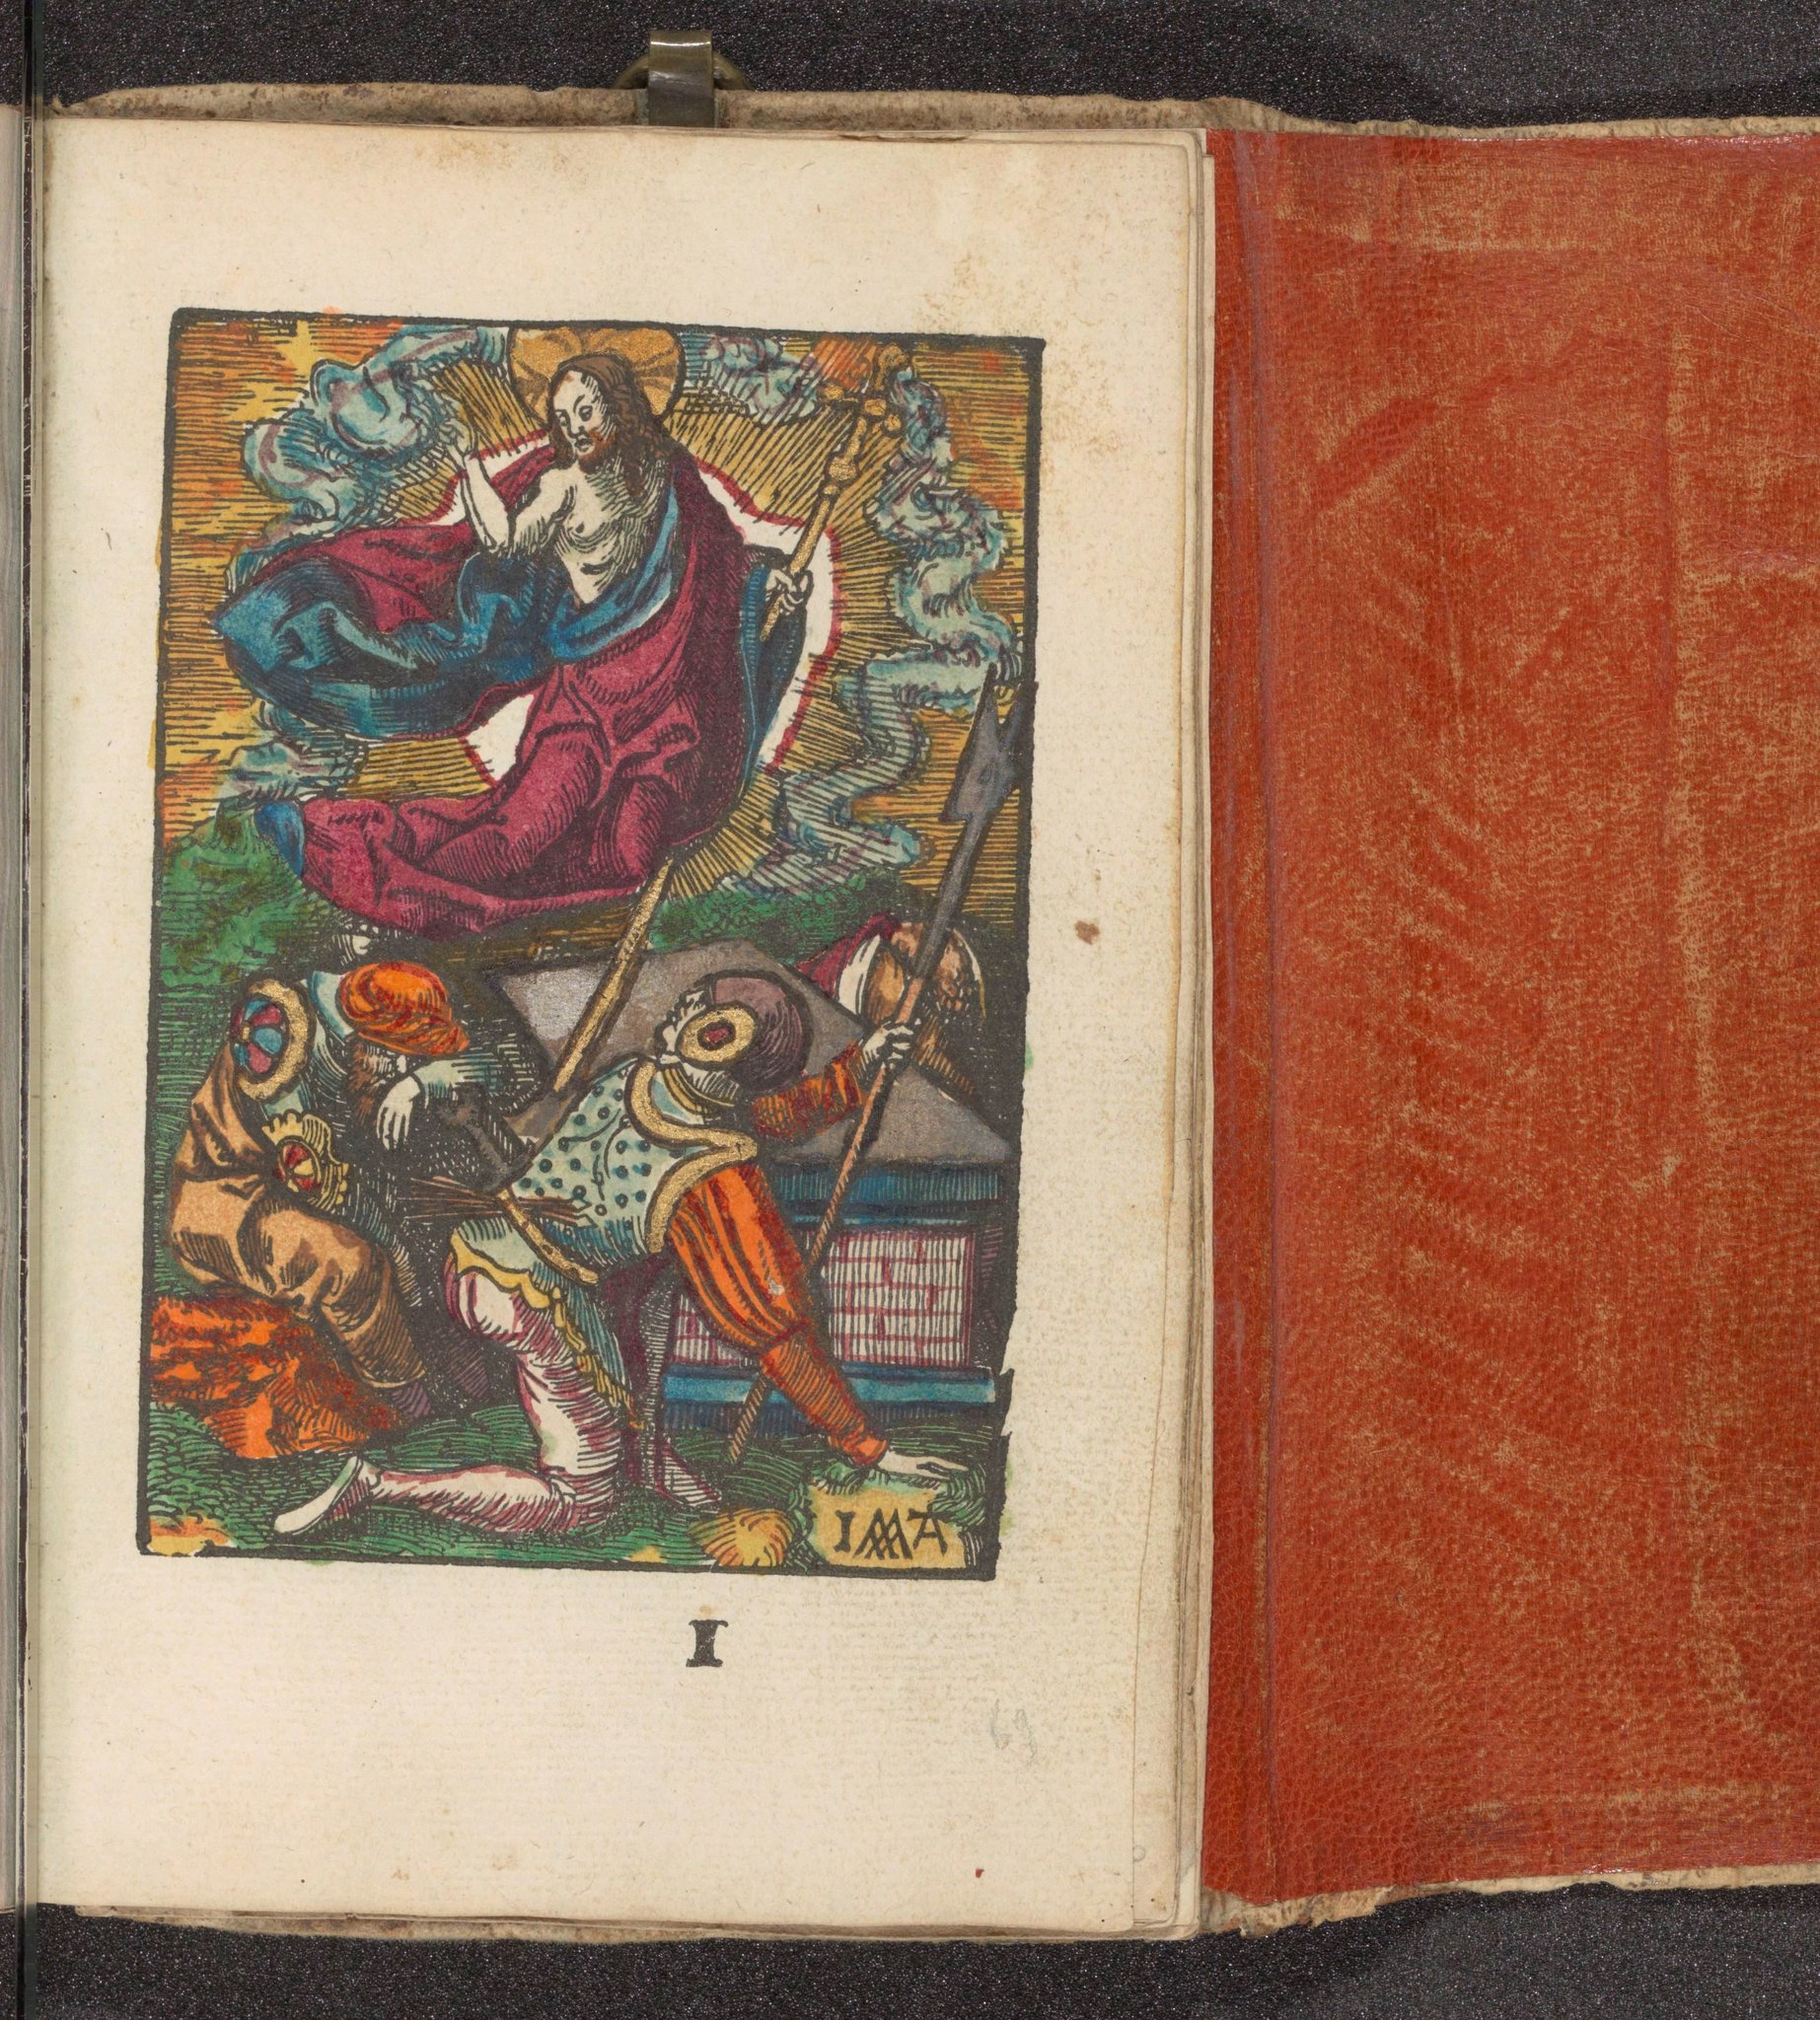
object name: album leaf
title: Opstanding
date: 1520-1521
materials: paper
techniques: hand coloring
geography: amsterdam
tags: book in which illustrations are essential, christ floating above or near the tomb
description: Christus staat op uit de dood. Hij zweeft boven het graf met een kruisstaf in de hand. Een soldaat kijkt op, de ander slaapt. Onderaan gemerkt: I. Prent maakt deel uit van een boek.